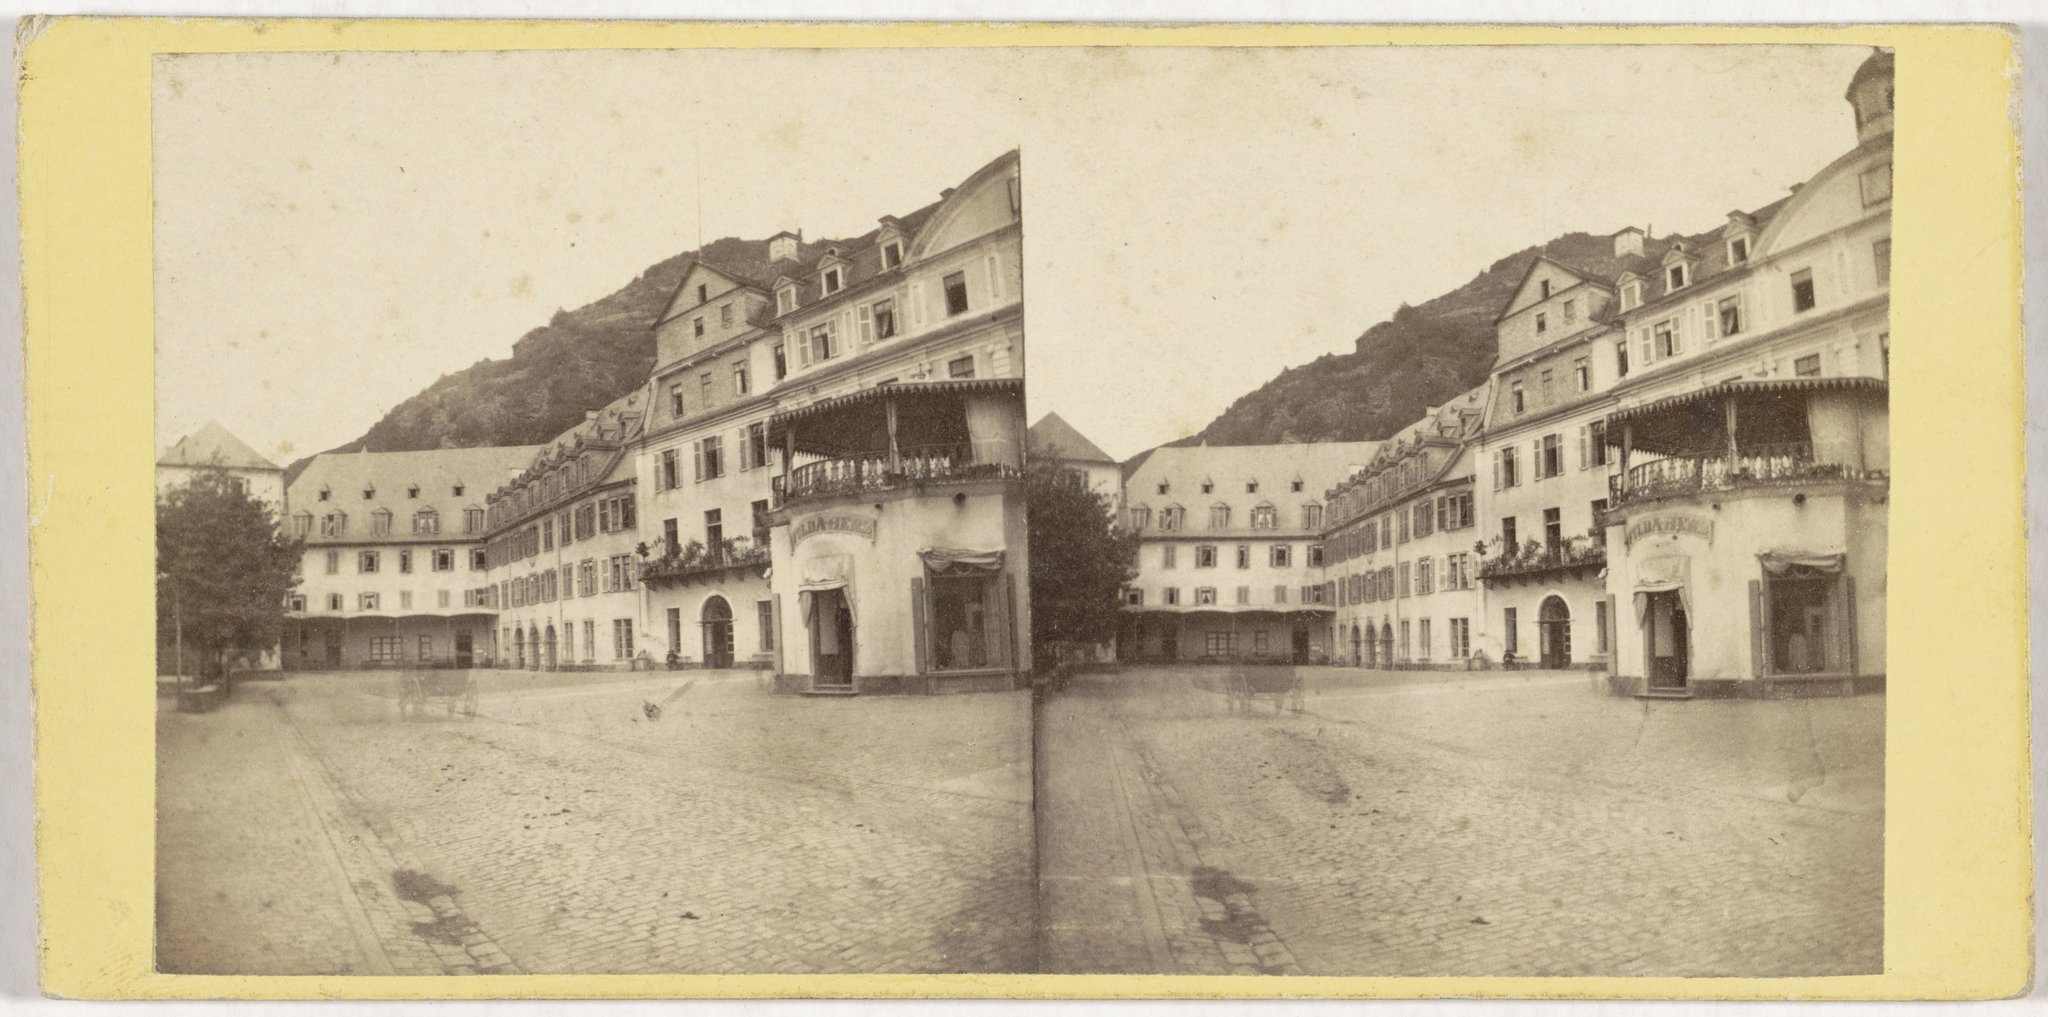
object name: stereograph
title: Le Kurhaus à Ems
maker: Anonymous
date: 1861-1870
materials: cardboard, paper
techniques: albumen print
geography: bad ems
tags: watering-place, spa, façade (of house or building), village square, place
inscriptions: number: ‘No 224.’